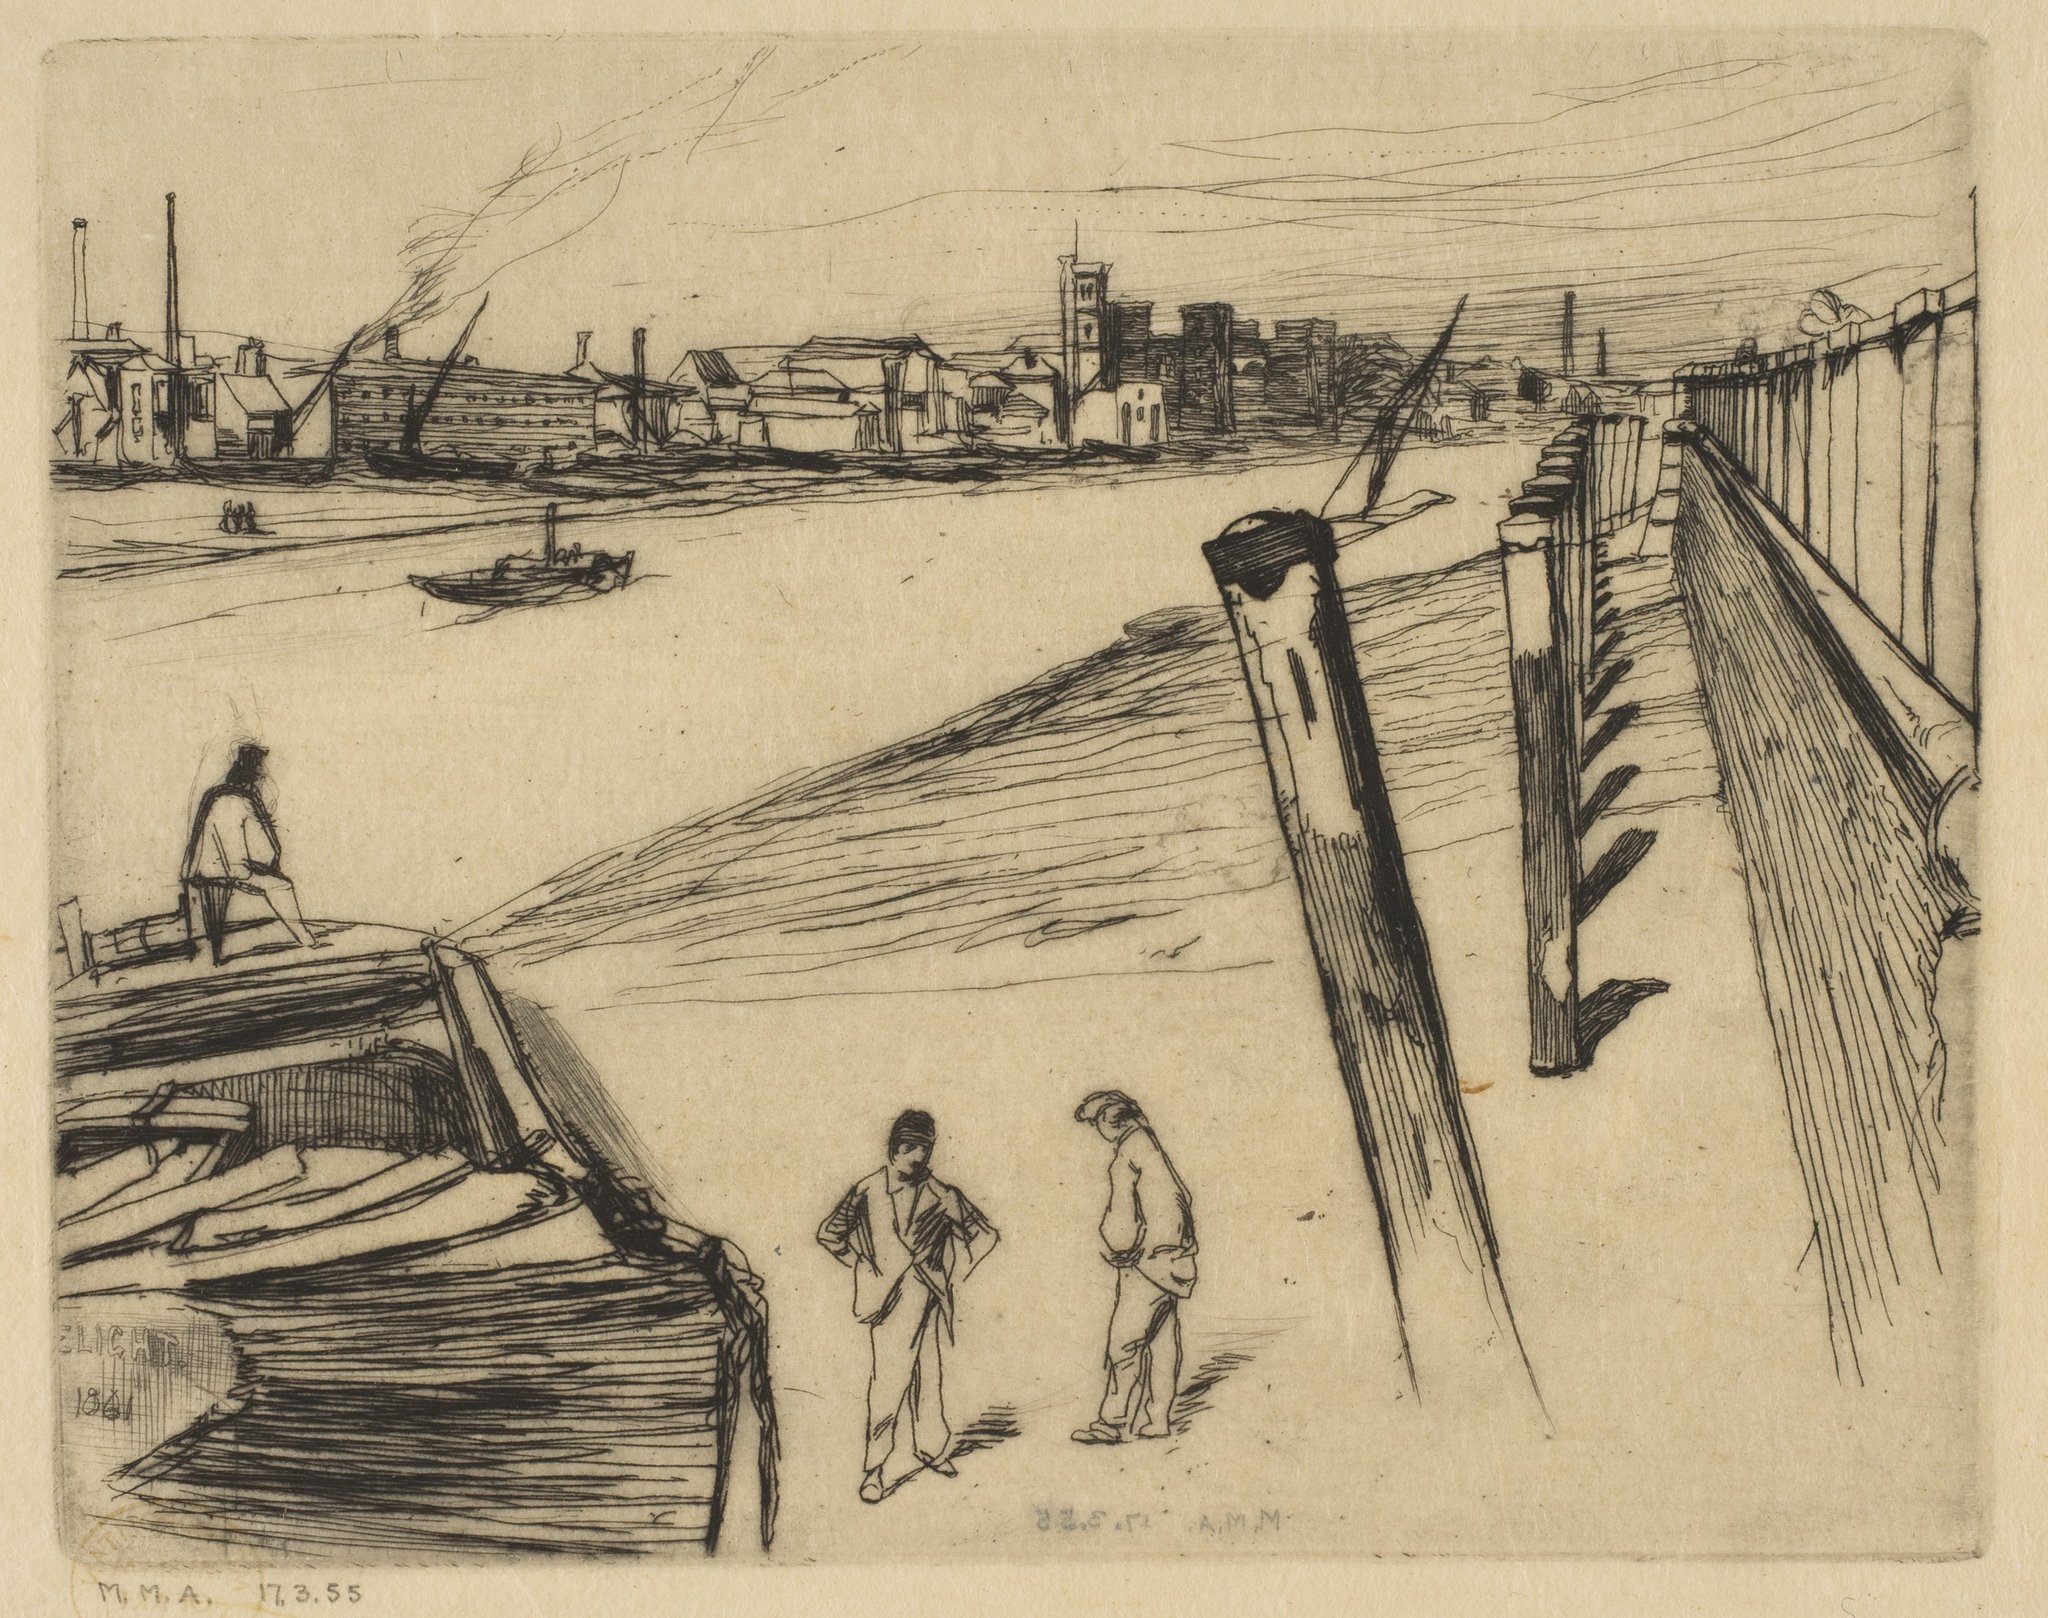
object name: print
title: Millbank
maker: james mcneill whistler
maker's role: artist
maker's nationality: american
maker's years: 1834-1903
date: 1861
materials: ink, ivory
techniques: drypoint, etching, printing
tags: rivers,boats